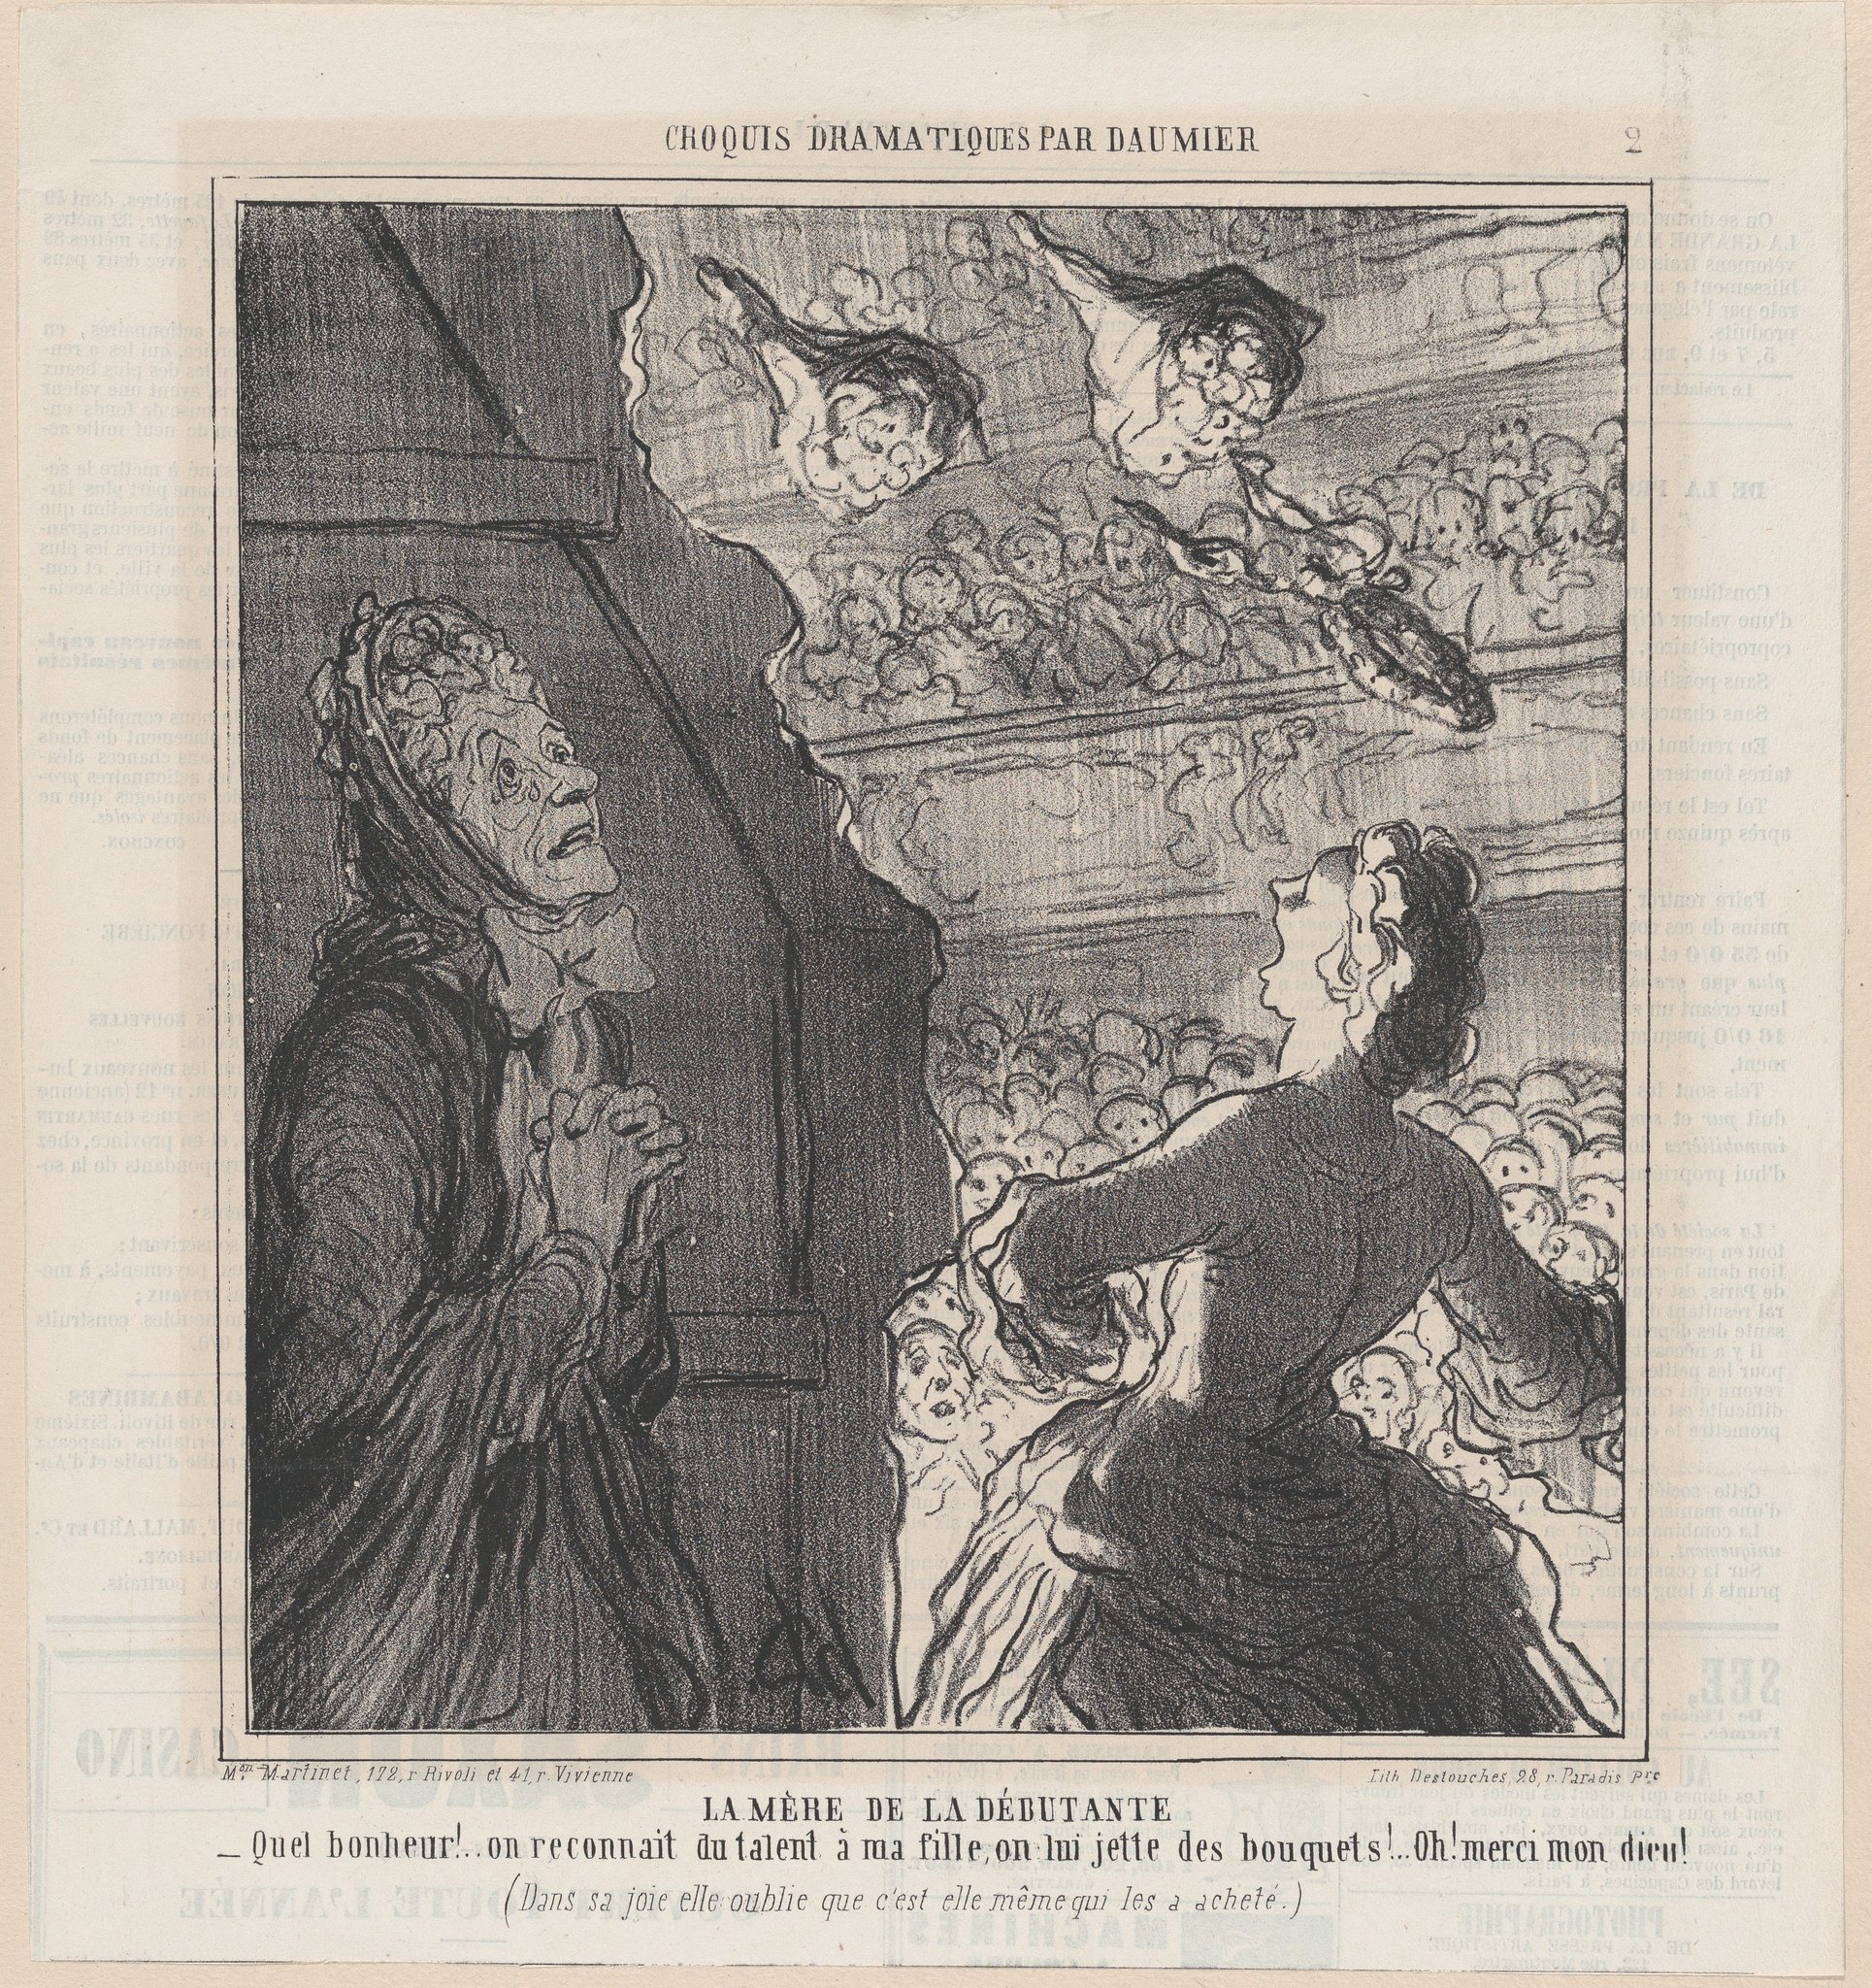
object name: print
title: The mother of the actress, from 'Dramatic sketches,' published in Le Charivari, July 2, 1864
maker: honoré daumier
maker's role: artist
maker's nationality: french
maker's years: 1808-1879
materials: paper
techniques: lithograph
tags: performance,mothers,women,actresses